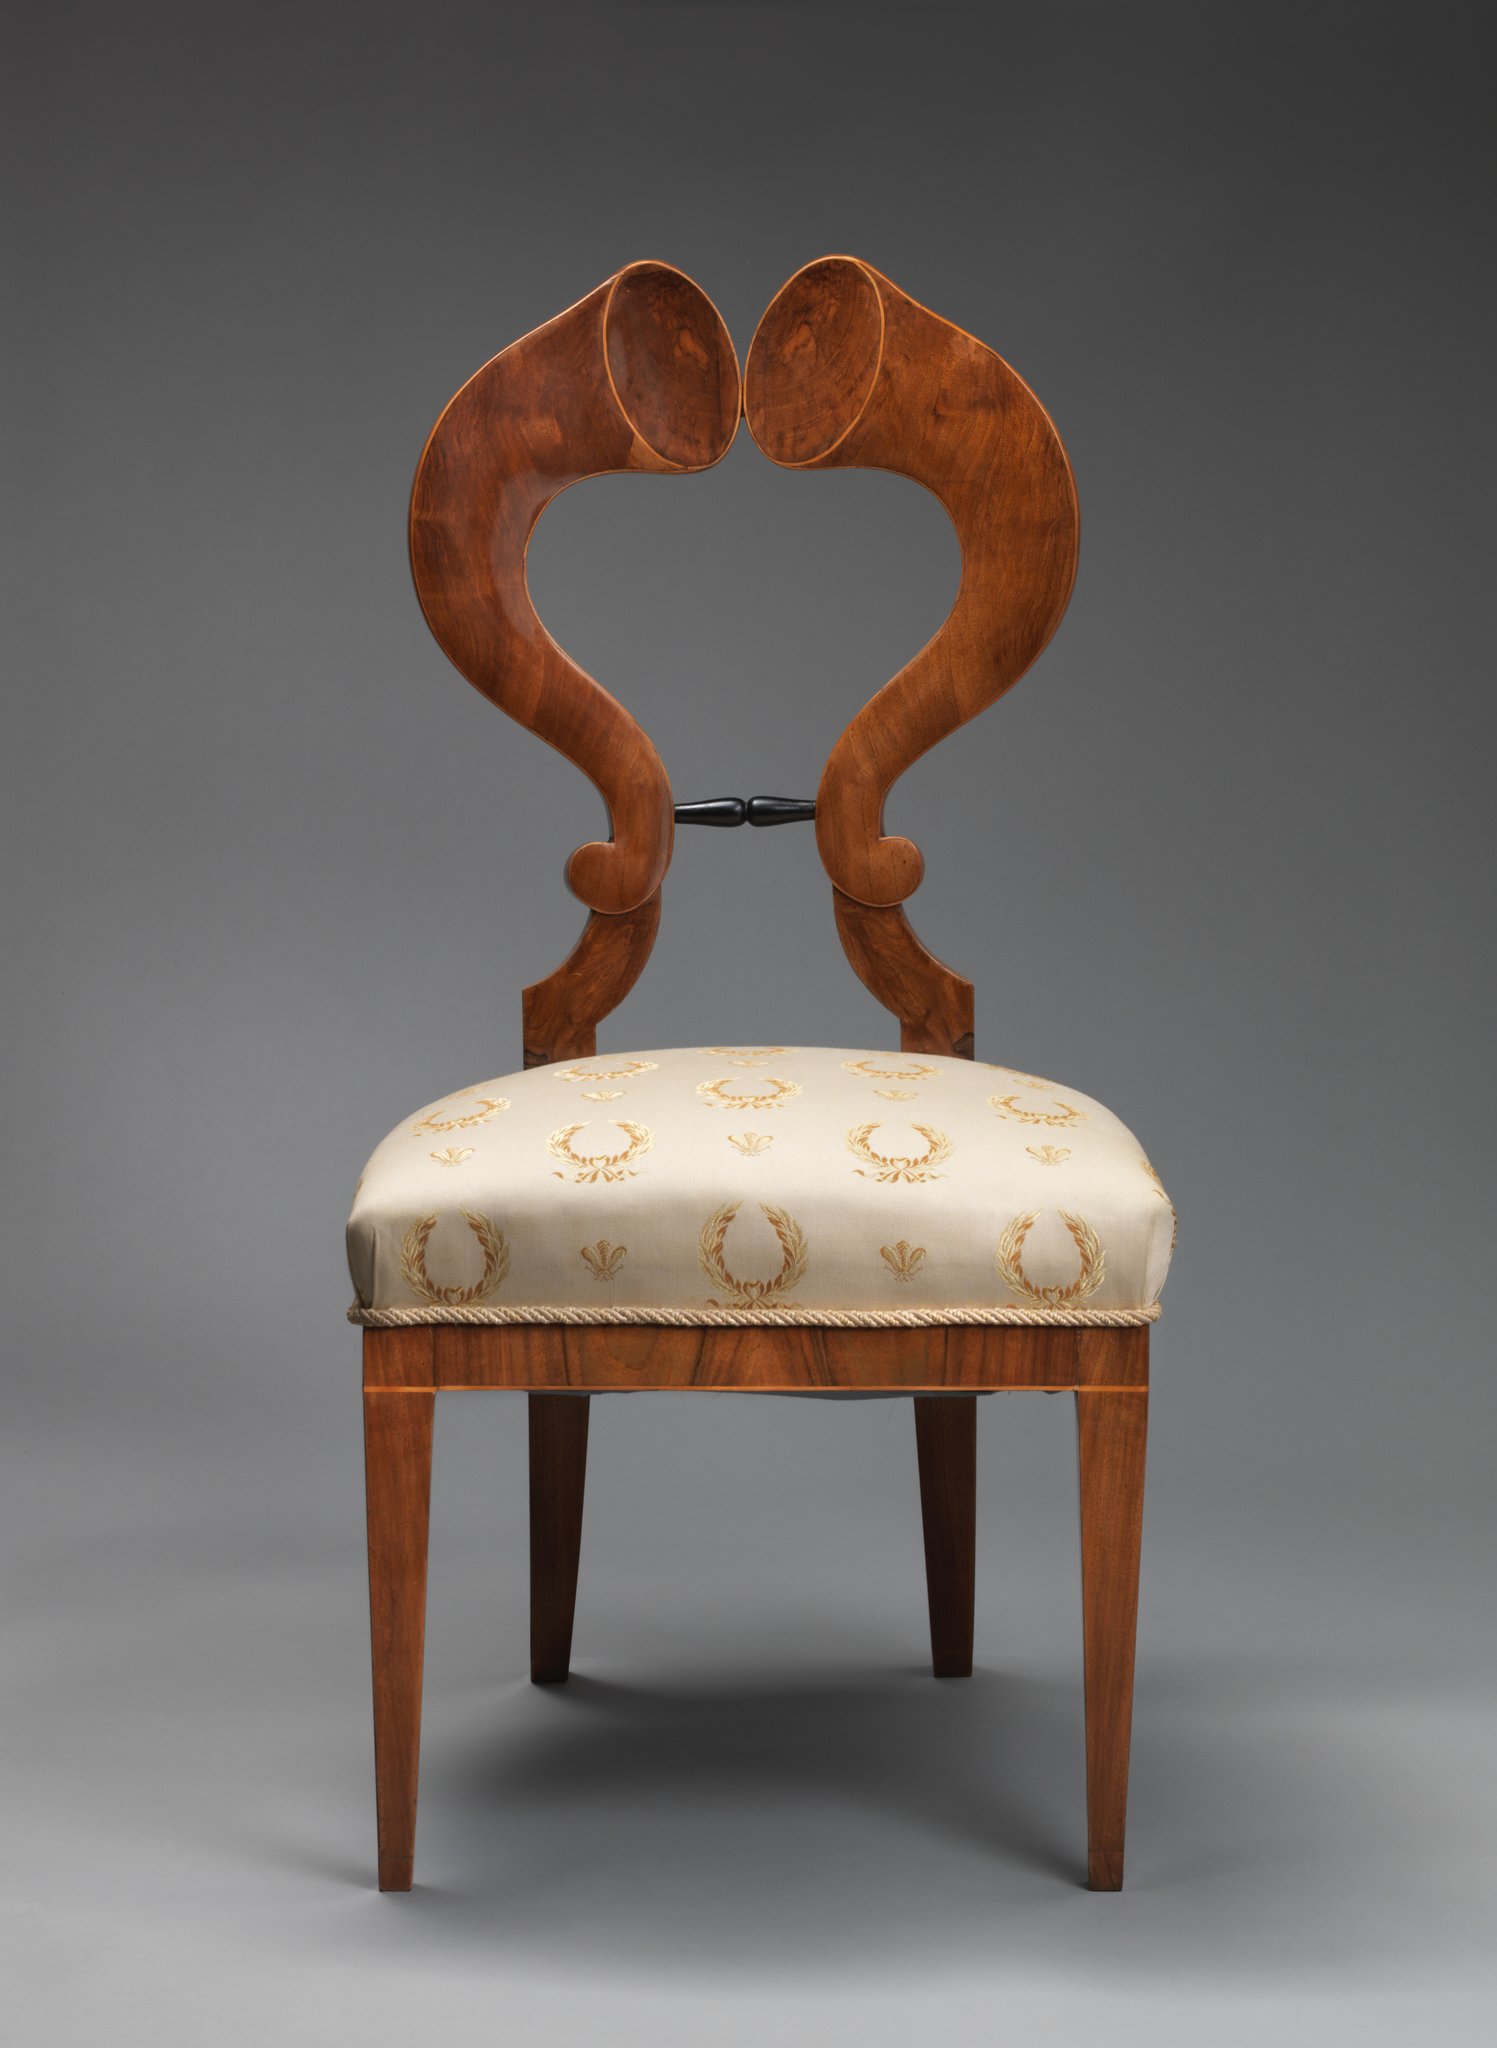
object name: chair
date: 1830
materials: wood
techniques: veneering